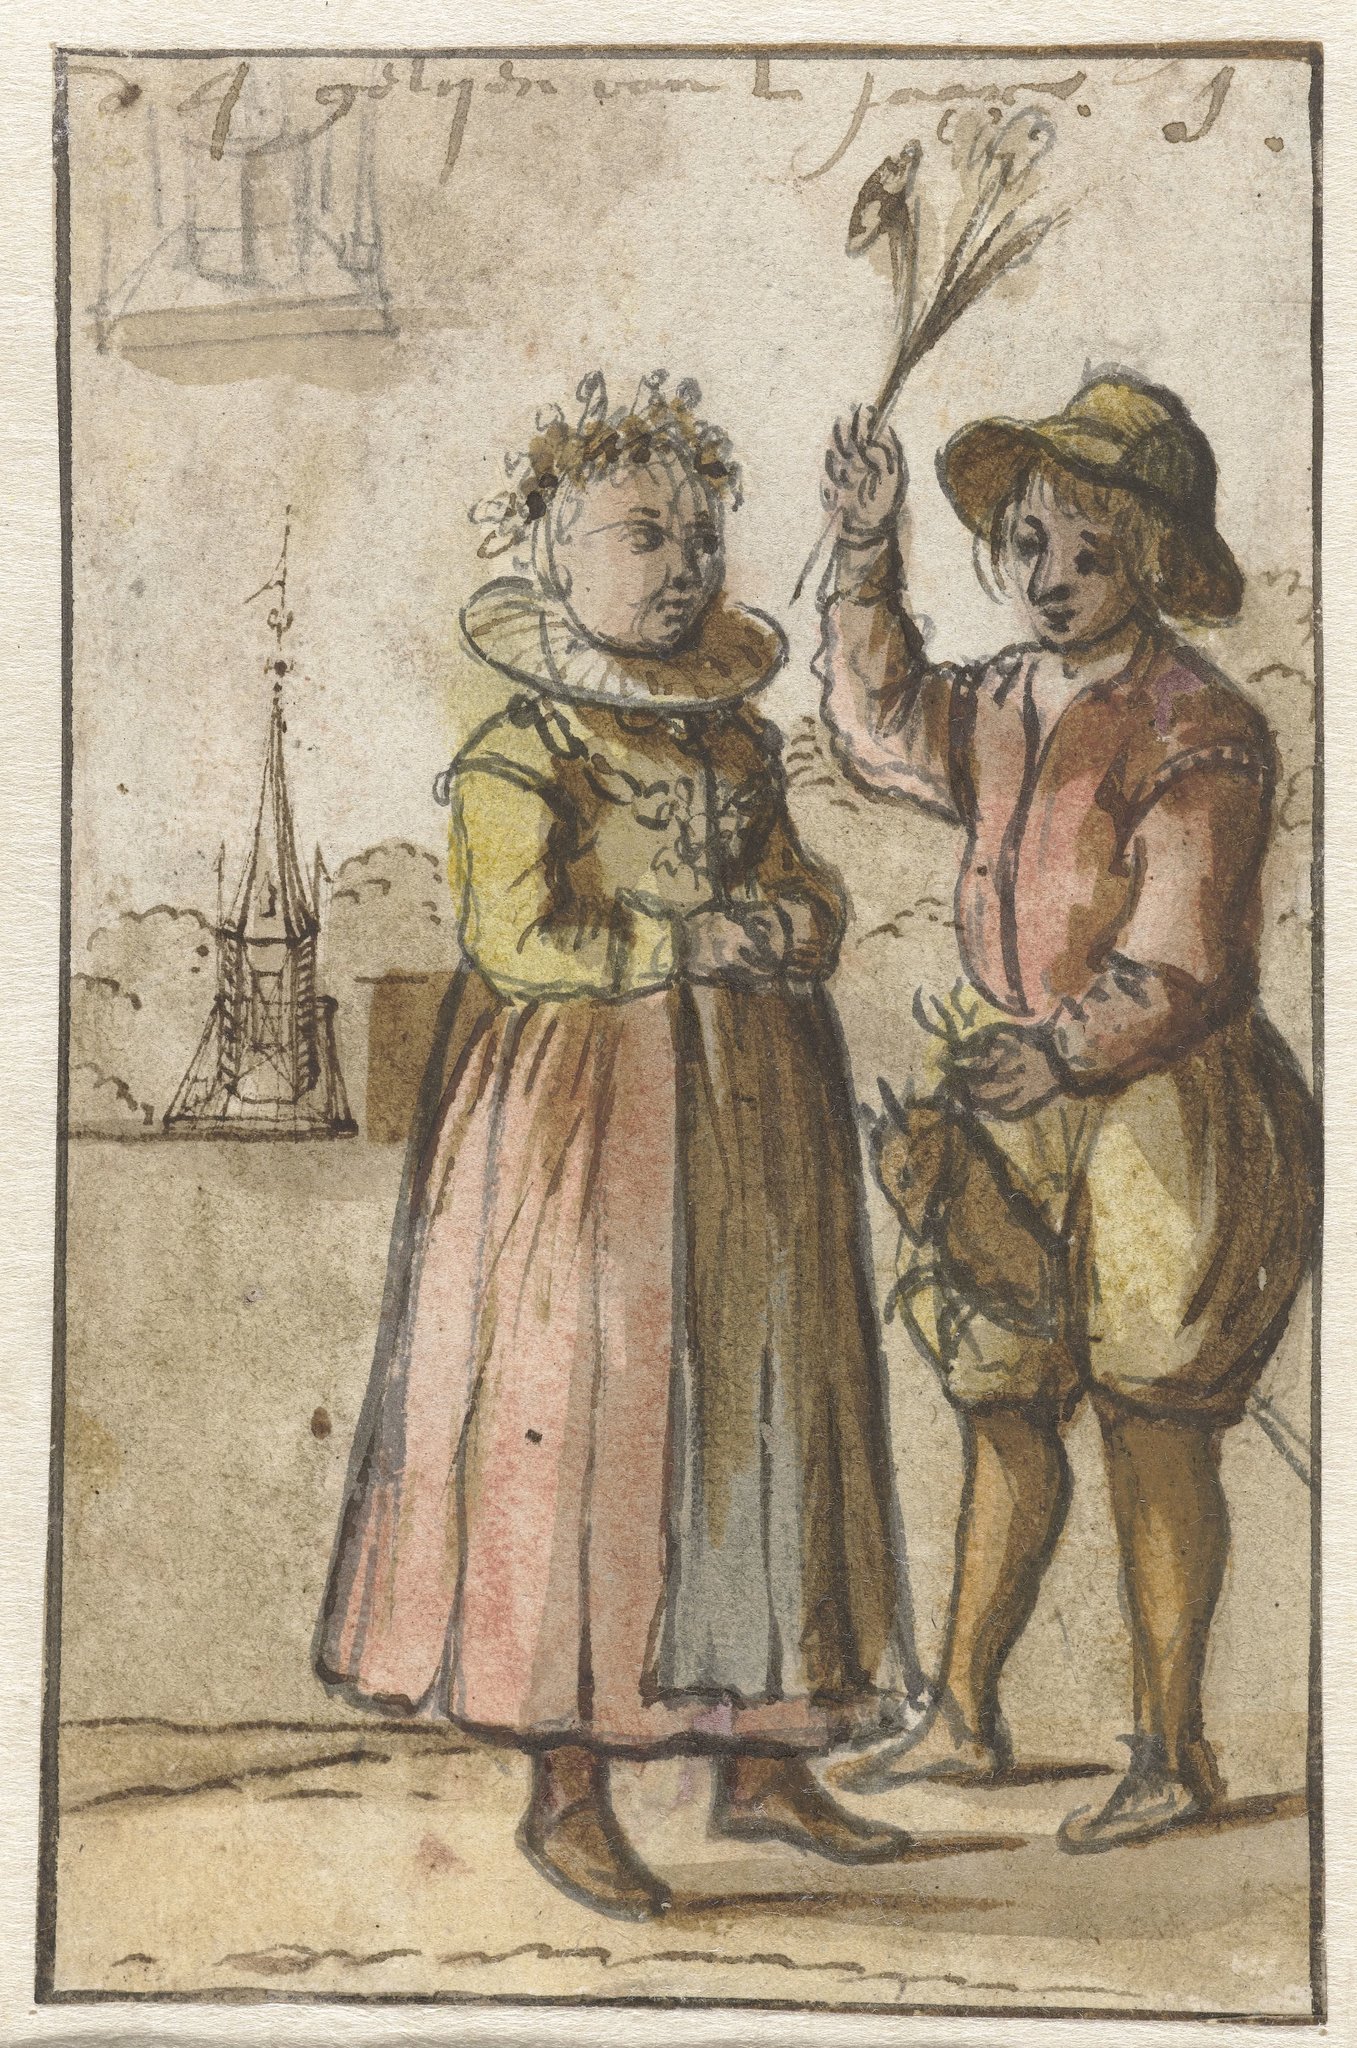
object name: drawing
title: Vier seizoenen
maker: Anonymous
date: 1600-1699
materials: ink, paper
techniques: brush, pen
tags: hobby-horse, spring ~ human activities (the four seasons of the year), child with plant (games and plays)